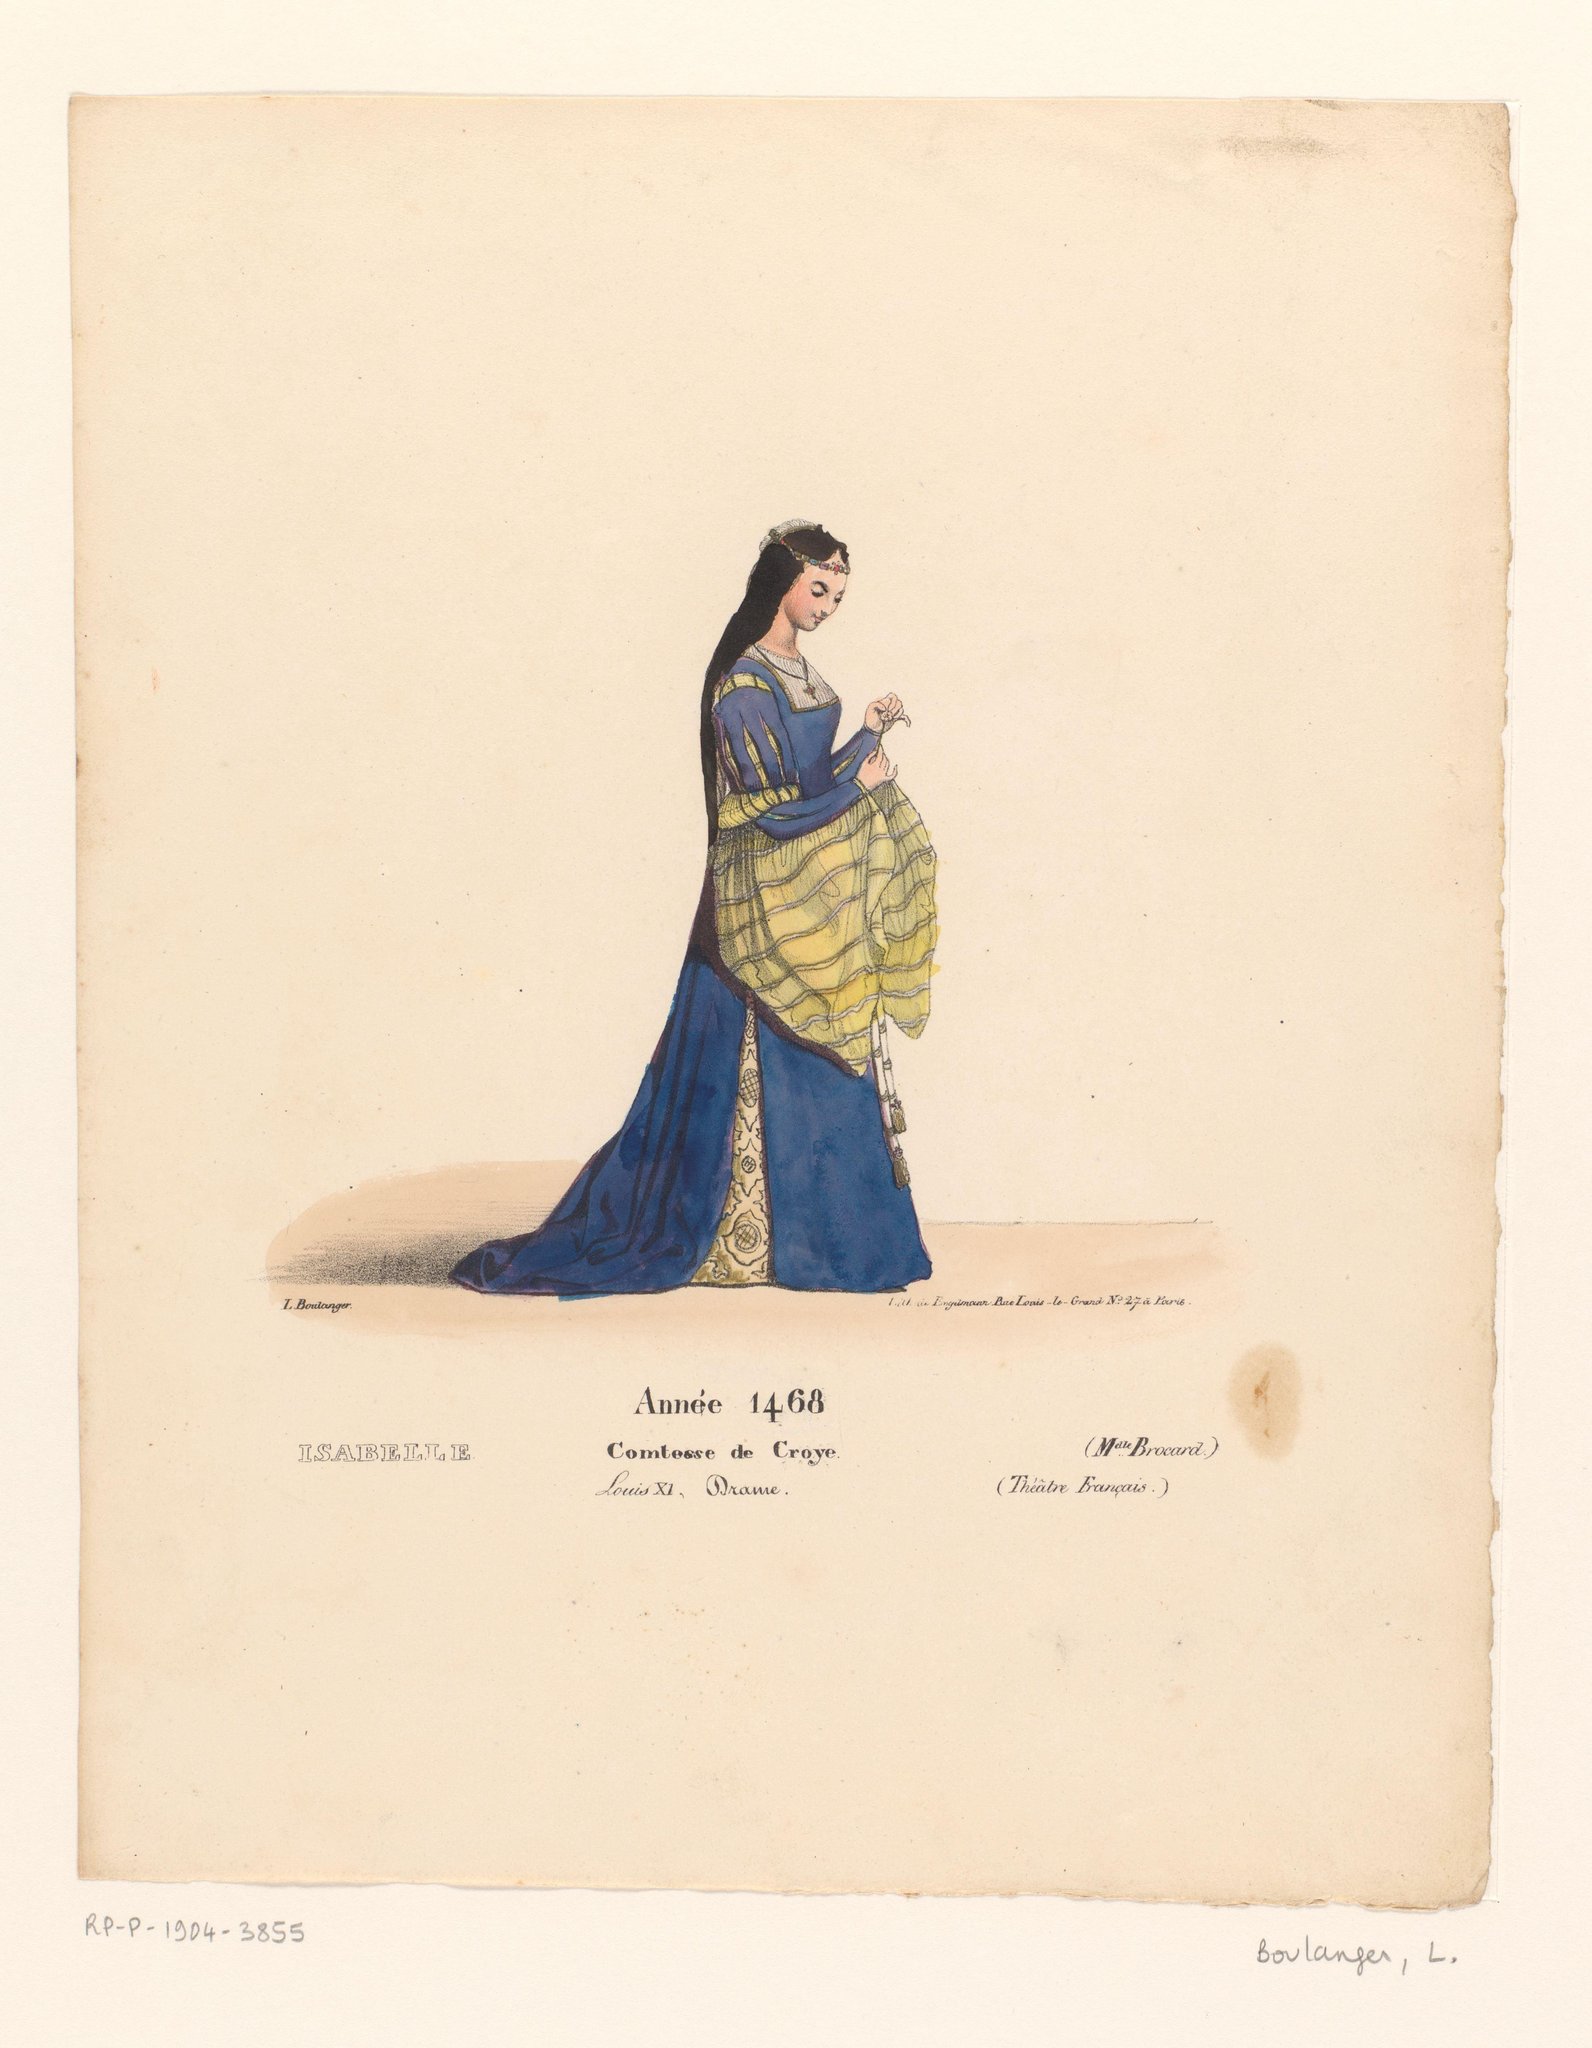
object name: print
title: Theaterkostuums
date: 1826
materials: paper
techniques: hand coloring, lithograph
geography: paris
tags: stage costume, actor (on the stage), tragedy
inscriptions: collector's mark: Lugt 2228a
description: Gravin Isabelle de Croye is een personage uit 'Quentin Durward' van Sir Walter Scott, het boek waar het toneelstuk 'Louis XI à Péronne' op is gebaseerd.